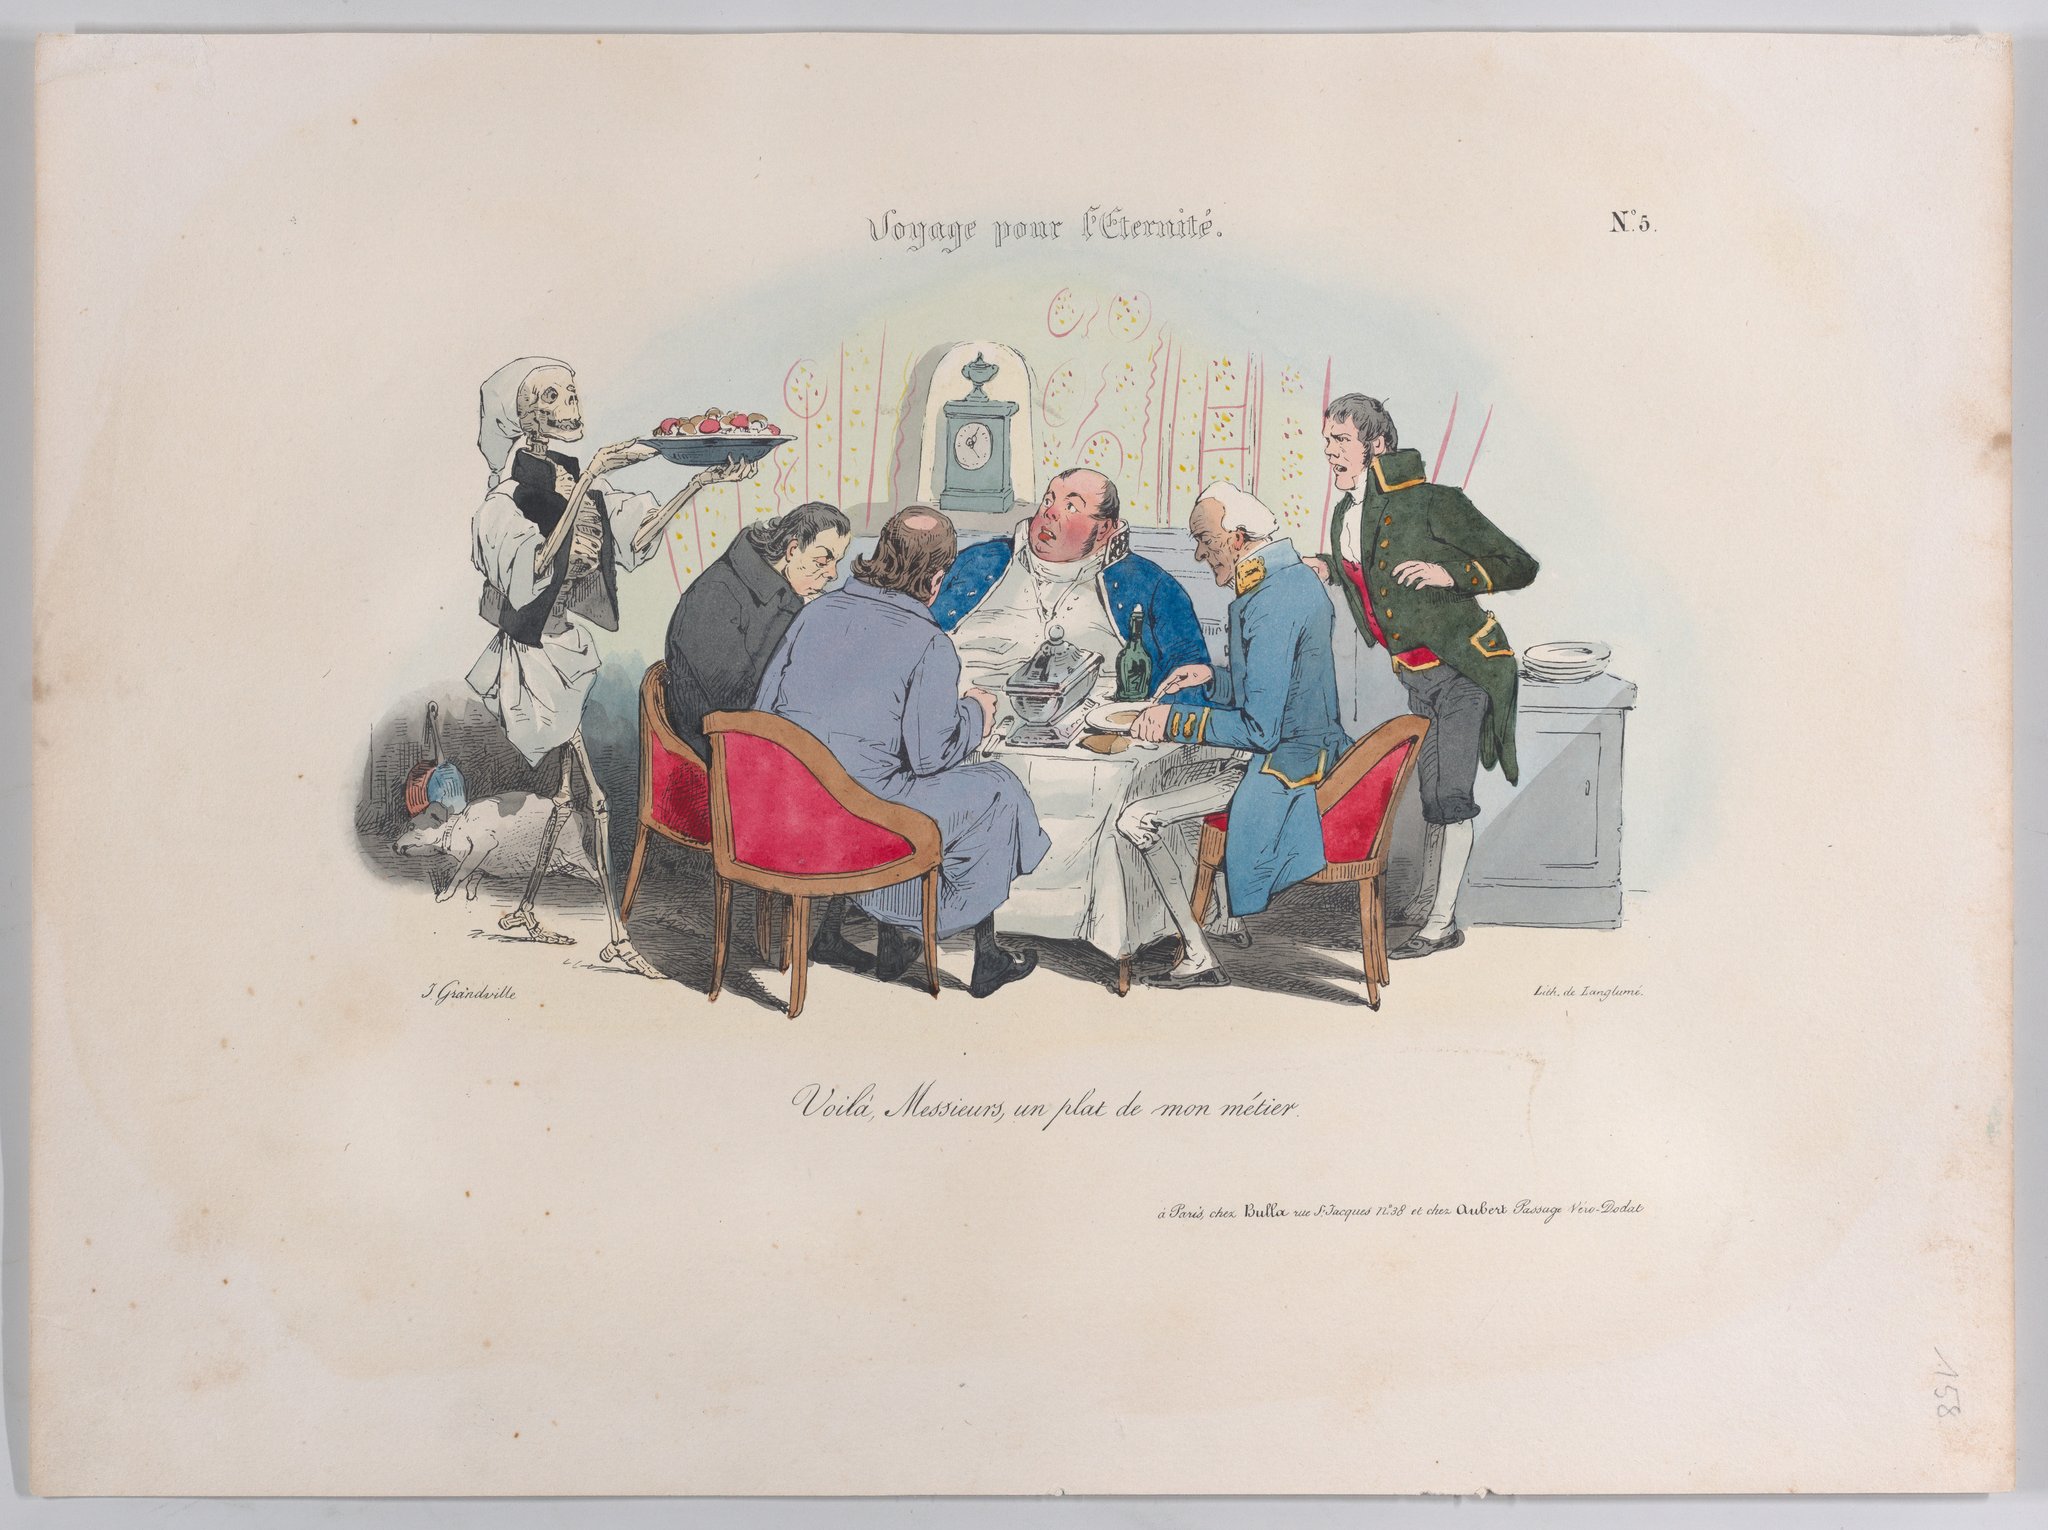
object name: print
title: Journey for Eternity, No. 6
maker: j. j. grandville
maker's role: designer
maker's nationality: french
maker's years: 1803-1847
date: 1839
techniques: lithograph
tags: skeletons,men,dogs,dining